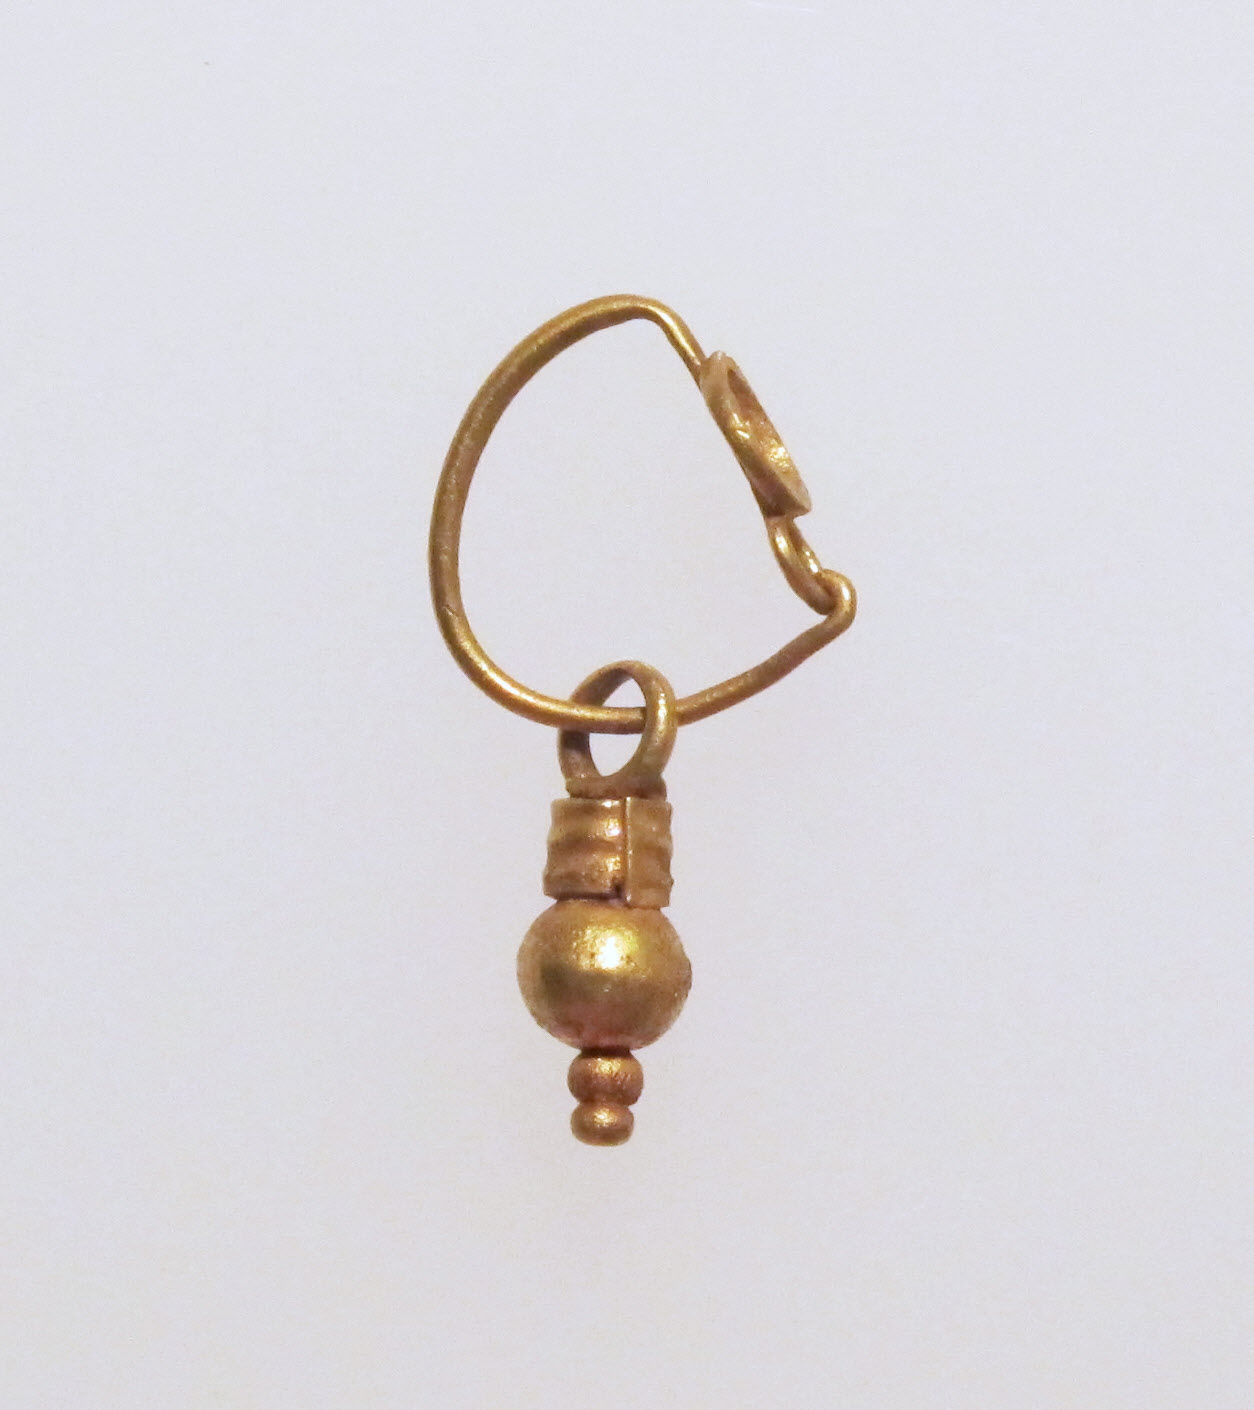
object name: earring with pendant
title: Gold earring with disc and pendant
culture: roman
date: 101-200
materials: gold